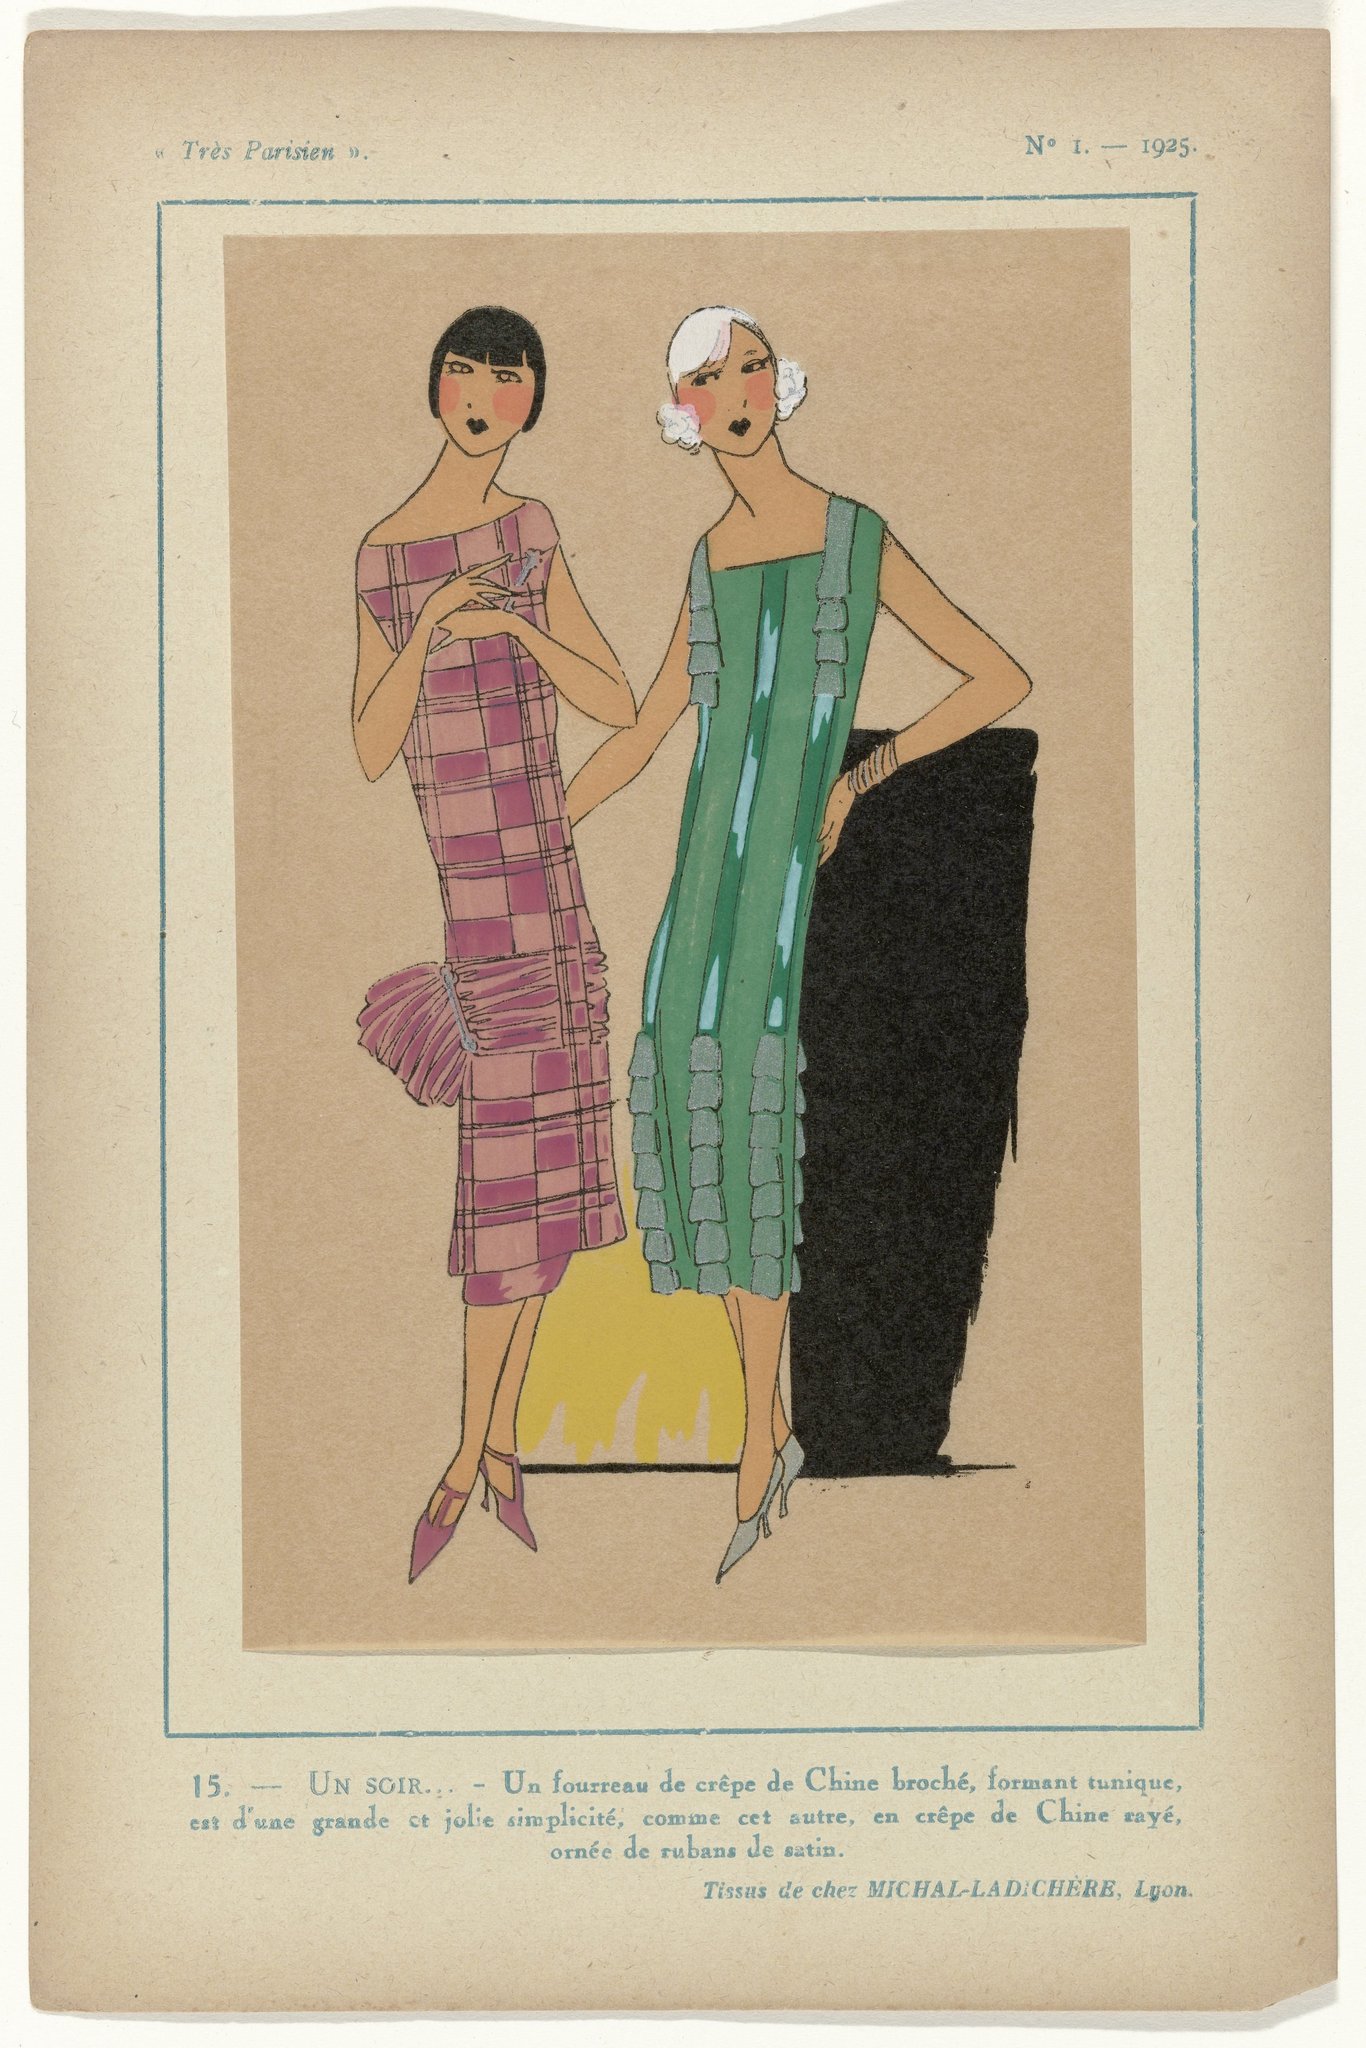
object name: fashion print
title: Très Parisien. La Mode, Le Chic, L’Elégance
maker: g-p. joumard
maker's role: publisher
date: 1925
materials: paper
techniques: hand coloring, letterpress printing, lithography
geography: paris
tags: dress, gown (afternoon dress) (+ women's clothes), fashion plates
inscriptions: caption: ‘UN SOIR...Un foureau de crêpe de Chine broché, formant tunique, est d'une grande et jolie simplicité, comme cet autre, en crêpe de Chine rayé, ornée de rubans de satin. Tissus de chez MICHAL-LADICHÈRE, Lyon.’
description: Très Parisien promoted itself as chic and elegant. Between 1920 and 1936 it presented creations by such couturiers as Chéruit, Premet, Philip et Gaston, and Lanvin. The young, svelte models are all ultra-modern, shown talking on the phone, smoking and playing tennis. The illustrations also show that over the course of the 1920s, skirt lengths had risen to just below the knee, before dropping back down to calf length in the 1930s. The small plates were printed on transparent paper using a stencilling technique known as en pochoir and then hand coloured; many of them are unsigned. The signature ‘Joujou’ belonged to Germaine Paule Joumard, who was the director of Très Parisien, as well as one of the magazine’s illustrators.